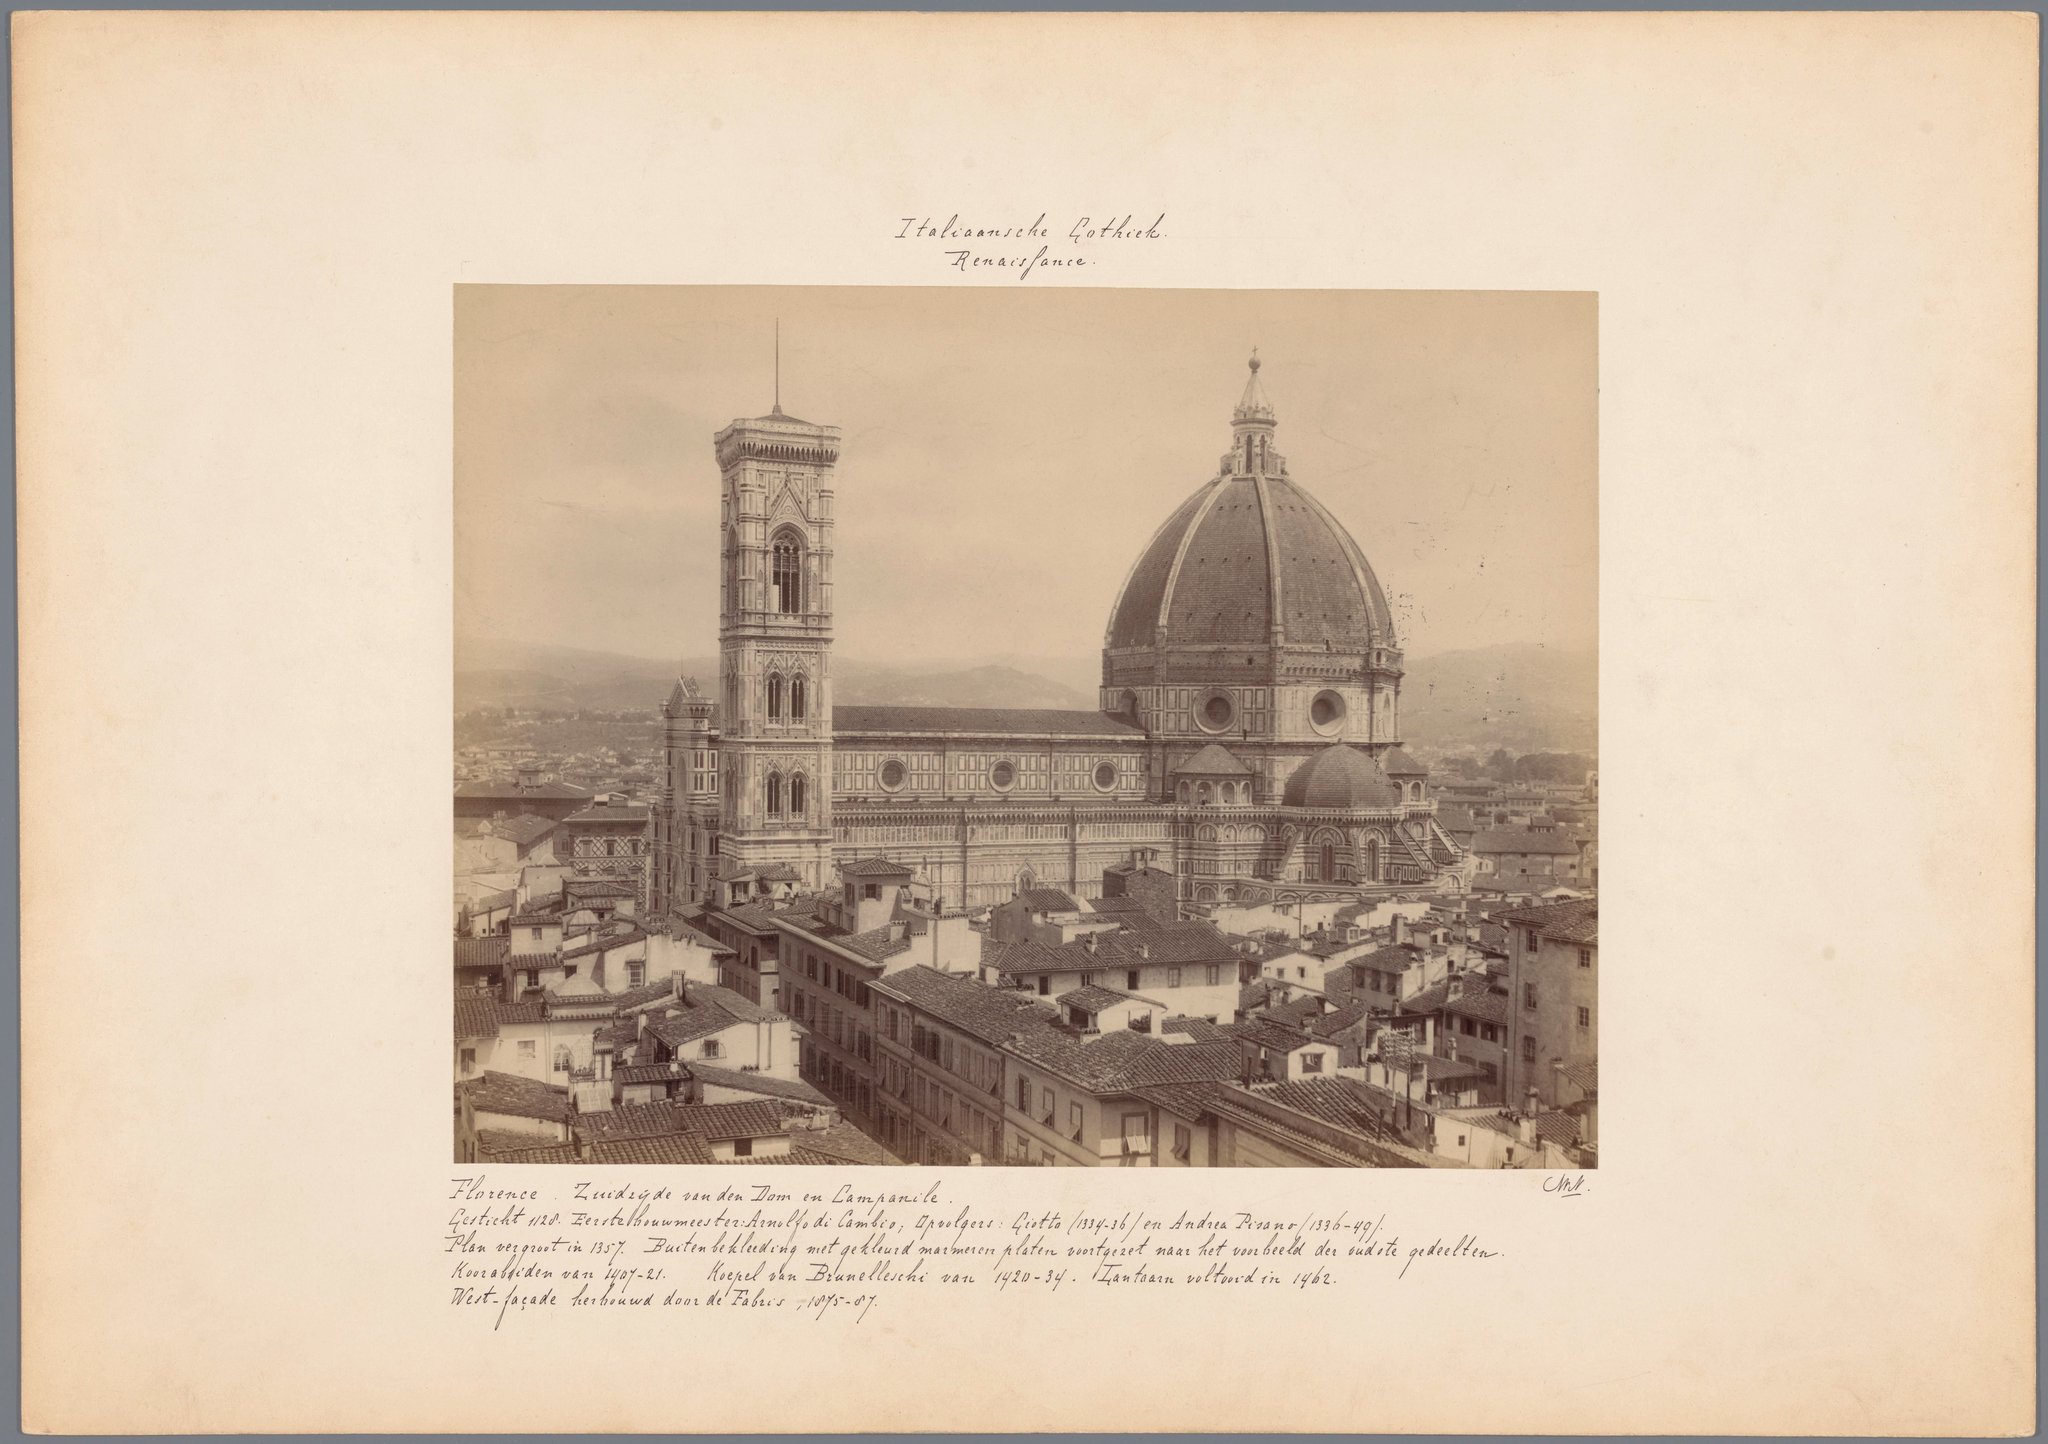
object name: photograph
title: Gezicht op de zuidzijde van de Dom te Florence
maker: Anonymous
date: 1875-1900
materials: cardboard, photographic support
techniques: albumen print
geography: florence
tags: parts of church exterior and annexes: campanile, church (exterior), dome ~ architecture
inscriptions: collector's mark: ‘KUNSTNIJVERHEIDSCHOOL QUELLINUS AMSTERDAM FRANS HALSSTRAAT 14.’, collector's mark: ‘INSTITUUT VOOR KUNST-NIJVERHEIDSONDERWIJS GABRIËL METSUSTRAAT No. 16 AMSTERDAM’, inscription: ‘CWN.’, inscription: ‘Italiaansche Gothiek. Renaissance.’